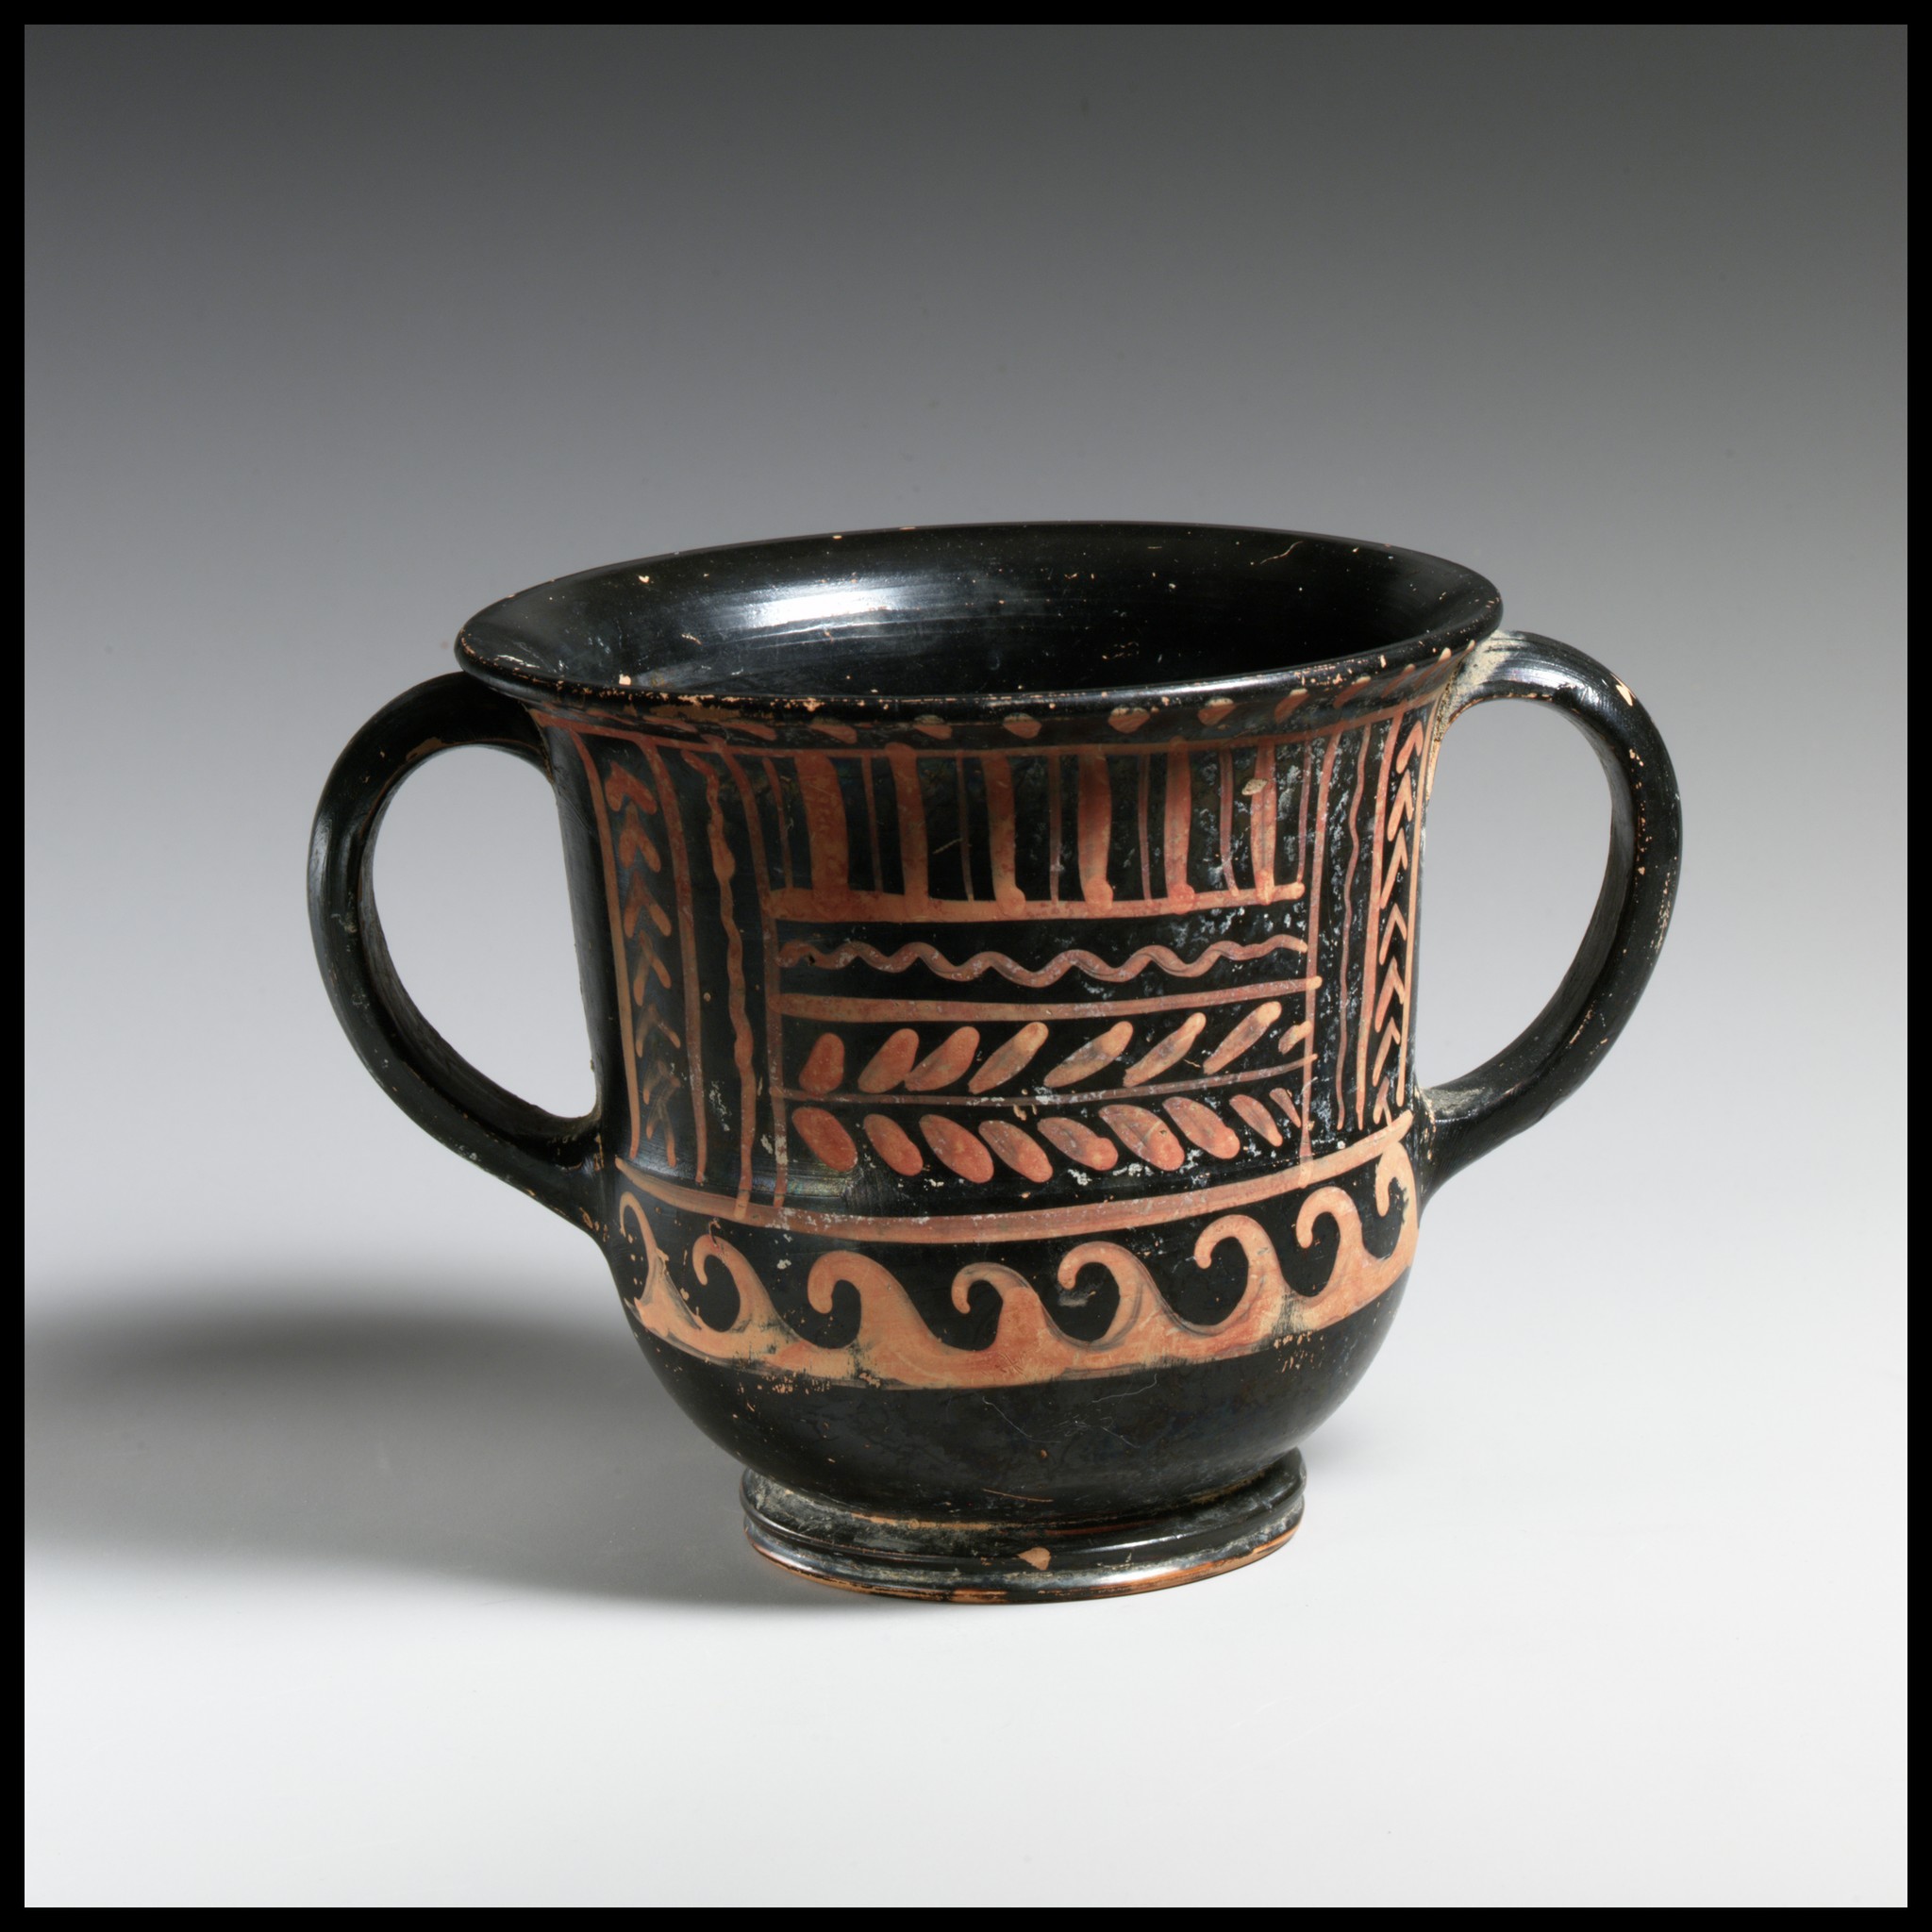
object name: kantharos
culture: greek, south italian, apulian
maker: xenon group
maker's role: artist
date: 400-301 BCE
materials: terracotta